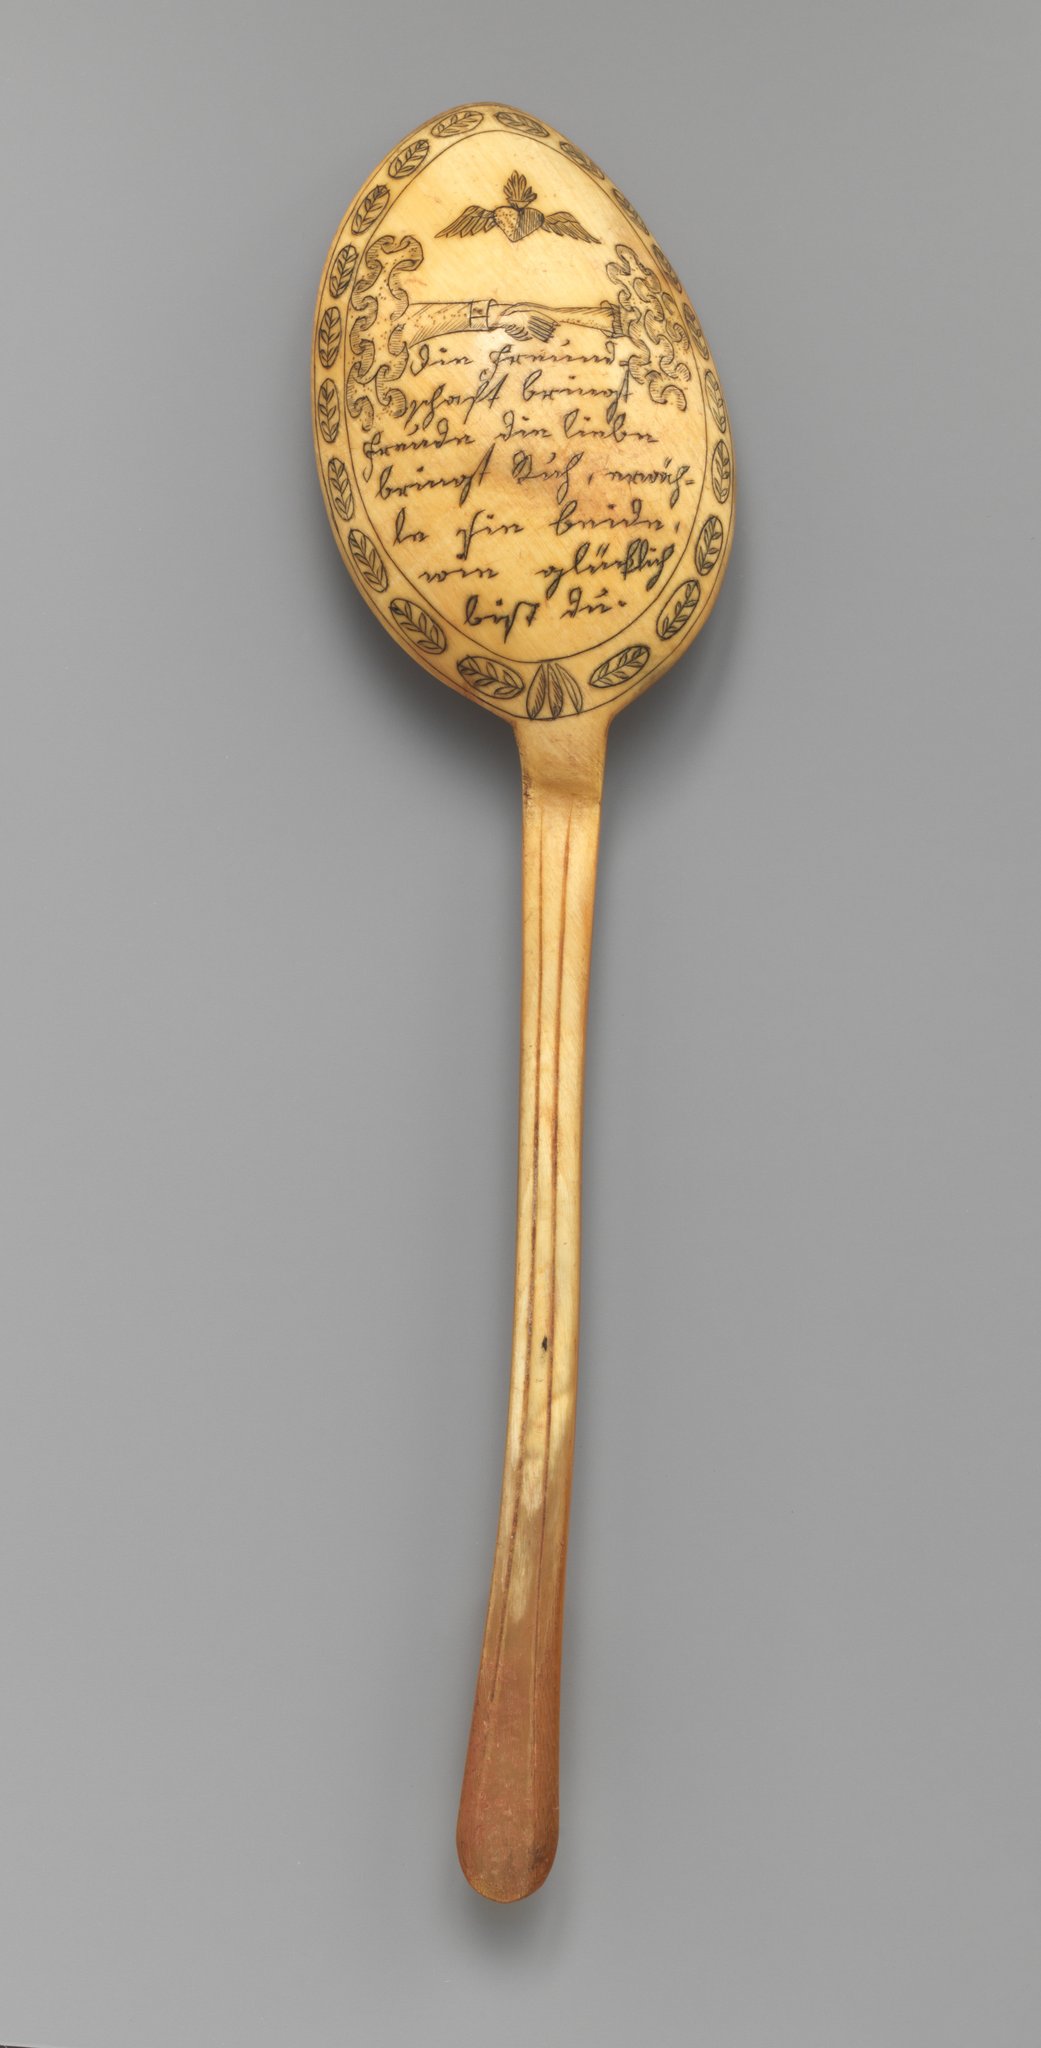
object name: spoon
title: Spoon with flaming heart and romantic inscription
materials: horn